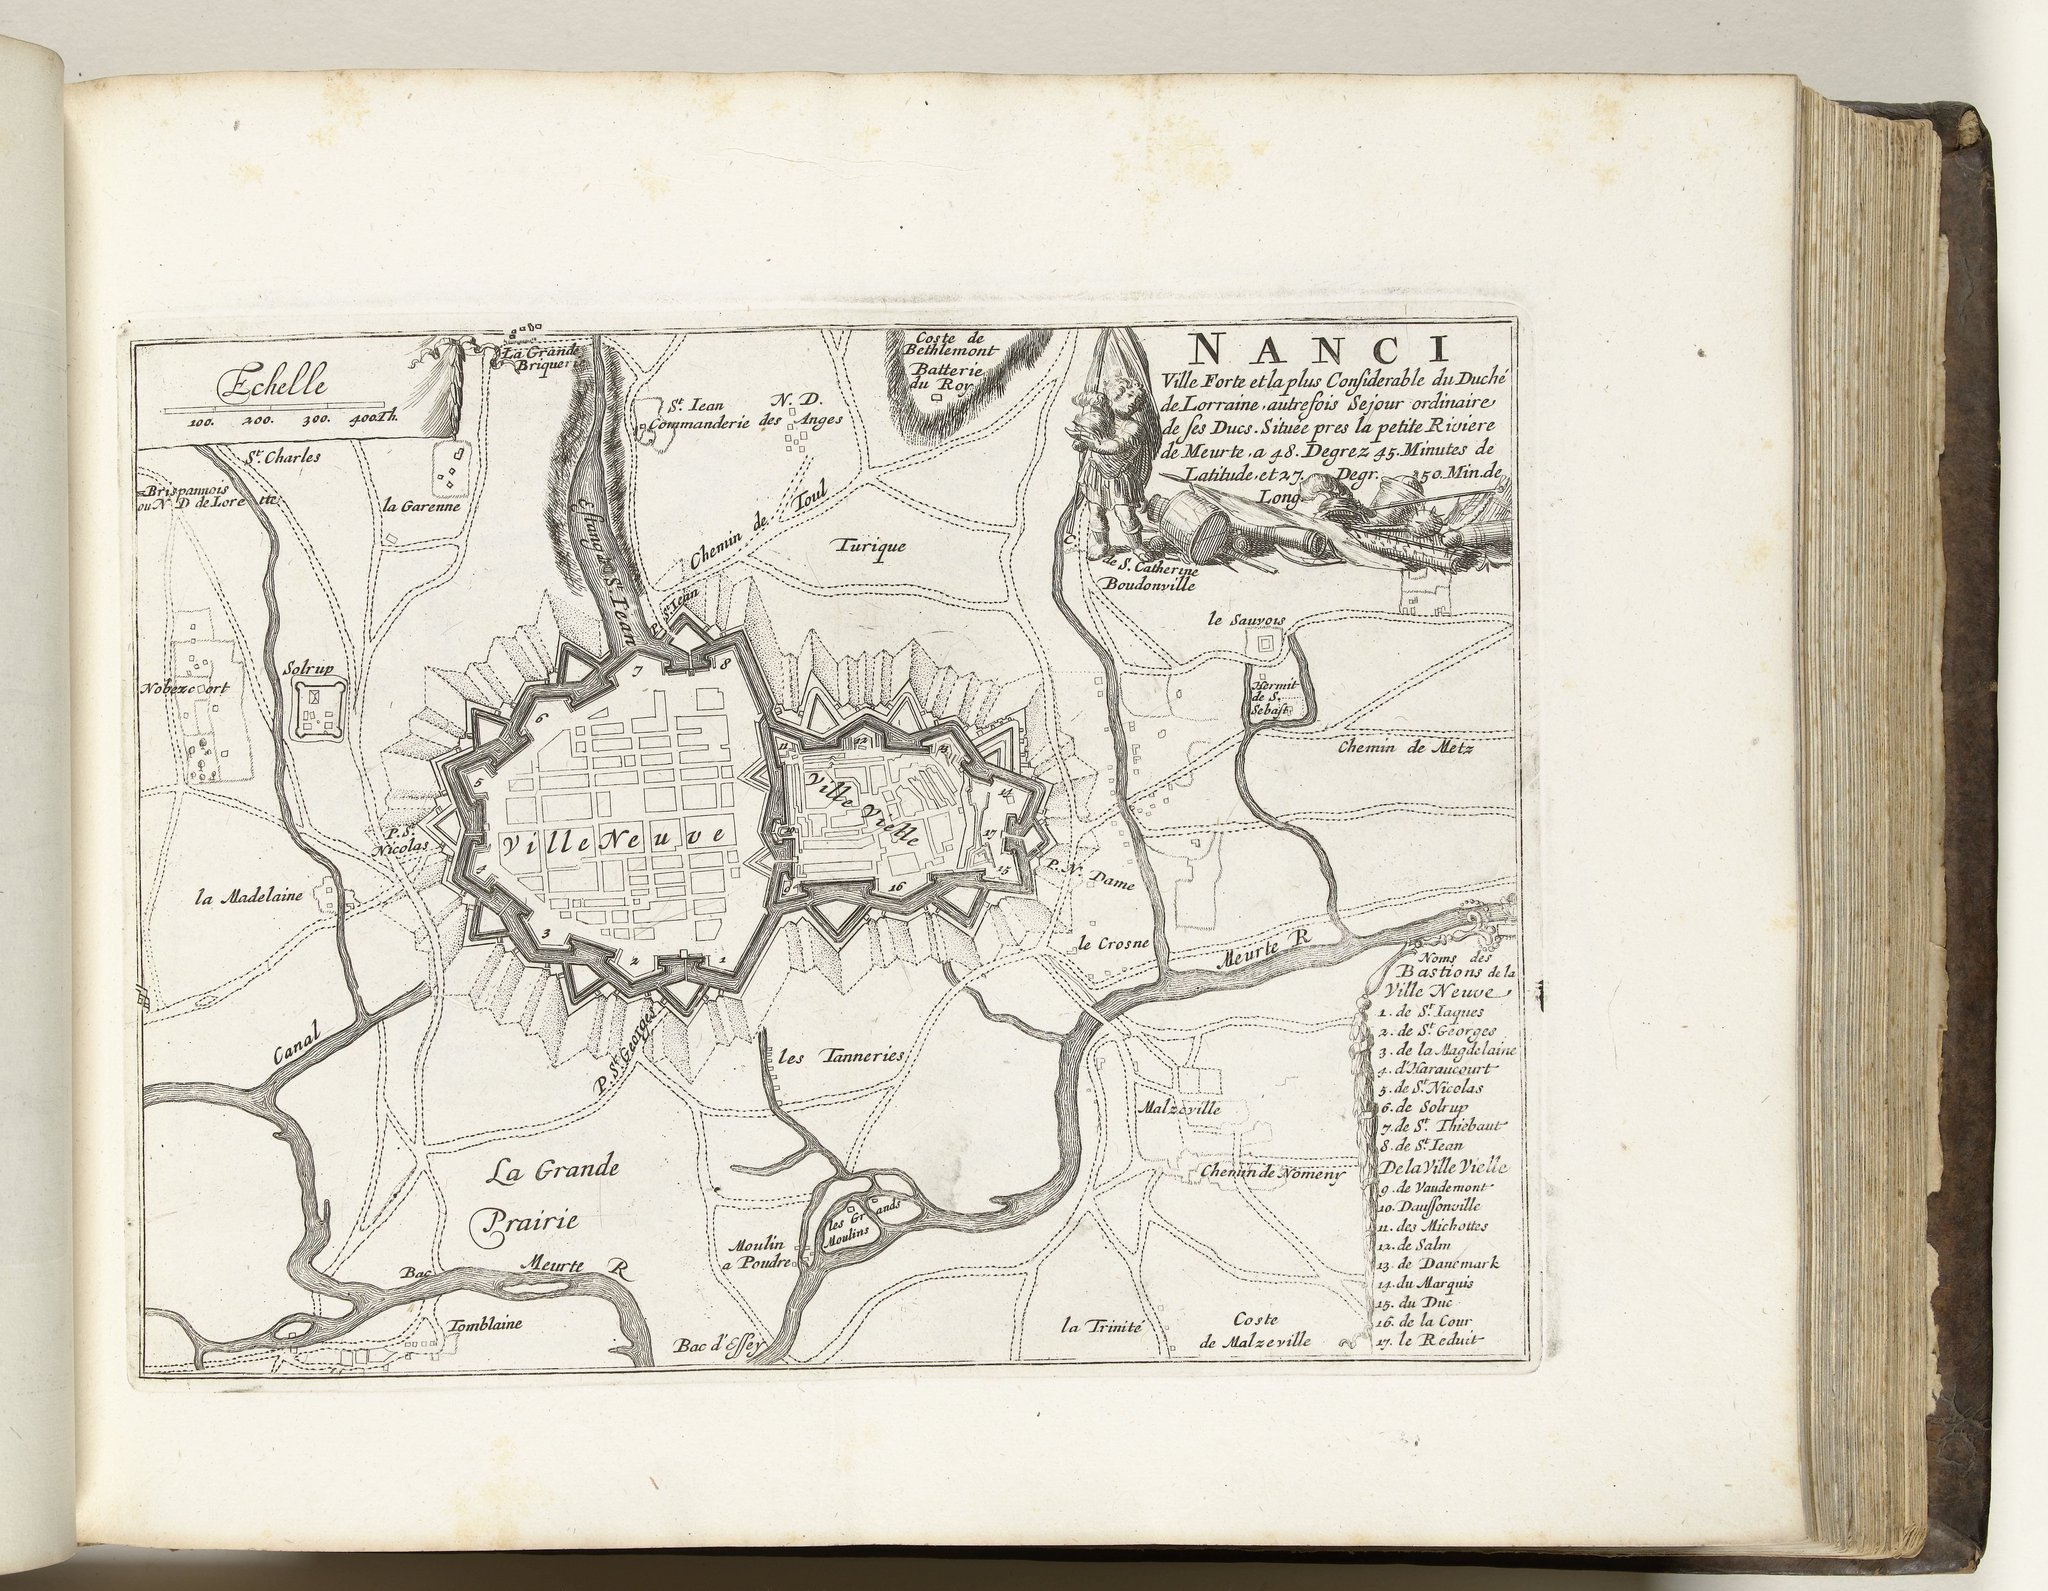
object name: print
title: Nanci Ville Forte et la plus Considerable du Duché de Lorraine (...)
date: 1695-1697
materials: paper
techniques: etching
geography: france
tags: fortress, maps of cities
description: Plattegrond van de versterkingen om de Franse stad Nancy. Onderdeel van het vierde deel (1697) van het prentwerk waarin gebundeld zijn de acht delen van Les forces de l'Europe uitgegeven tussen 1693-1697. Het prentwerk bestaat uit 175 platen met plannen (afkomstig van Sébastien Le Prestre, Seigneur de Vauban) van vermaarde sterke steden en vestingen in de Negenjarige Oorlog. Titel en opschriften in het Frans.